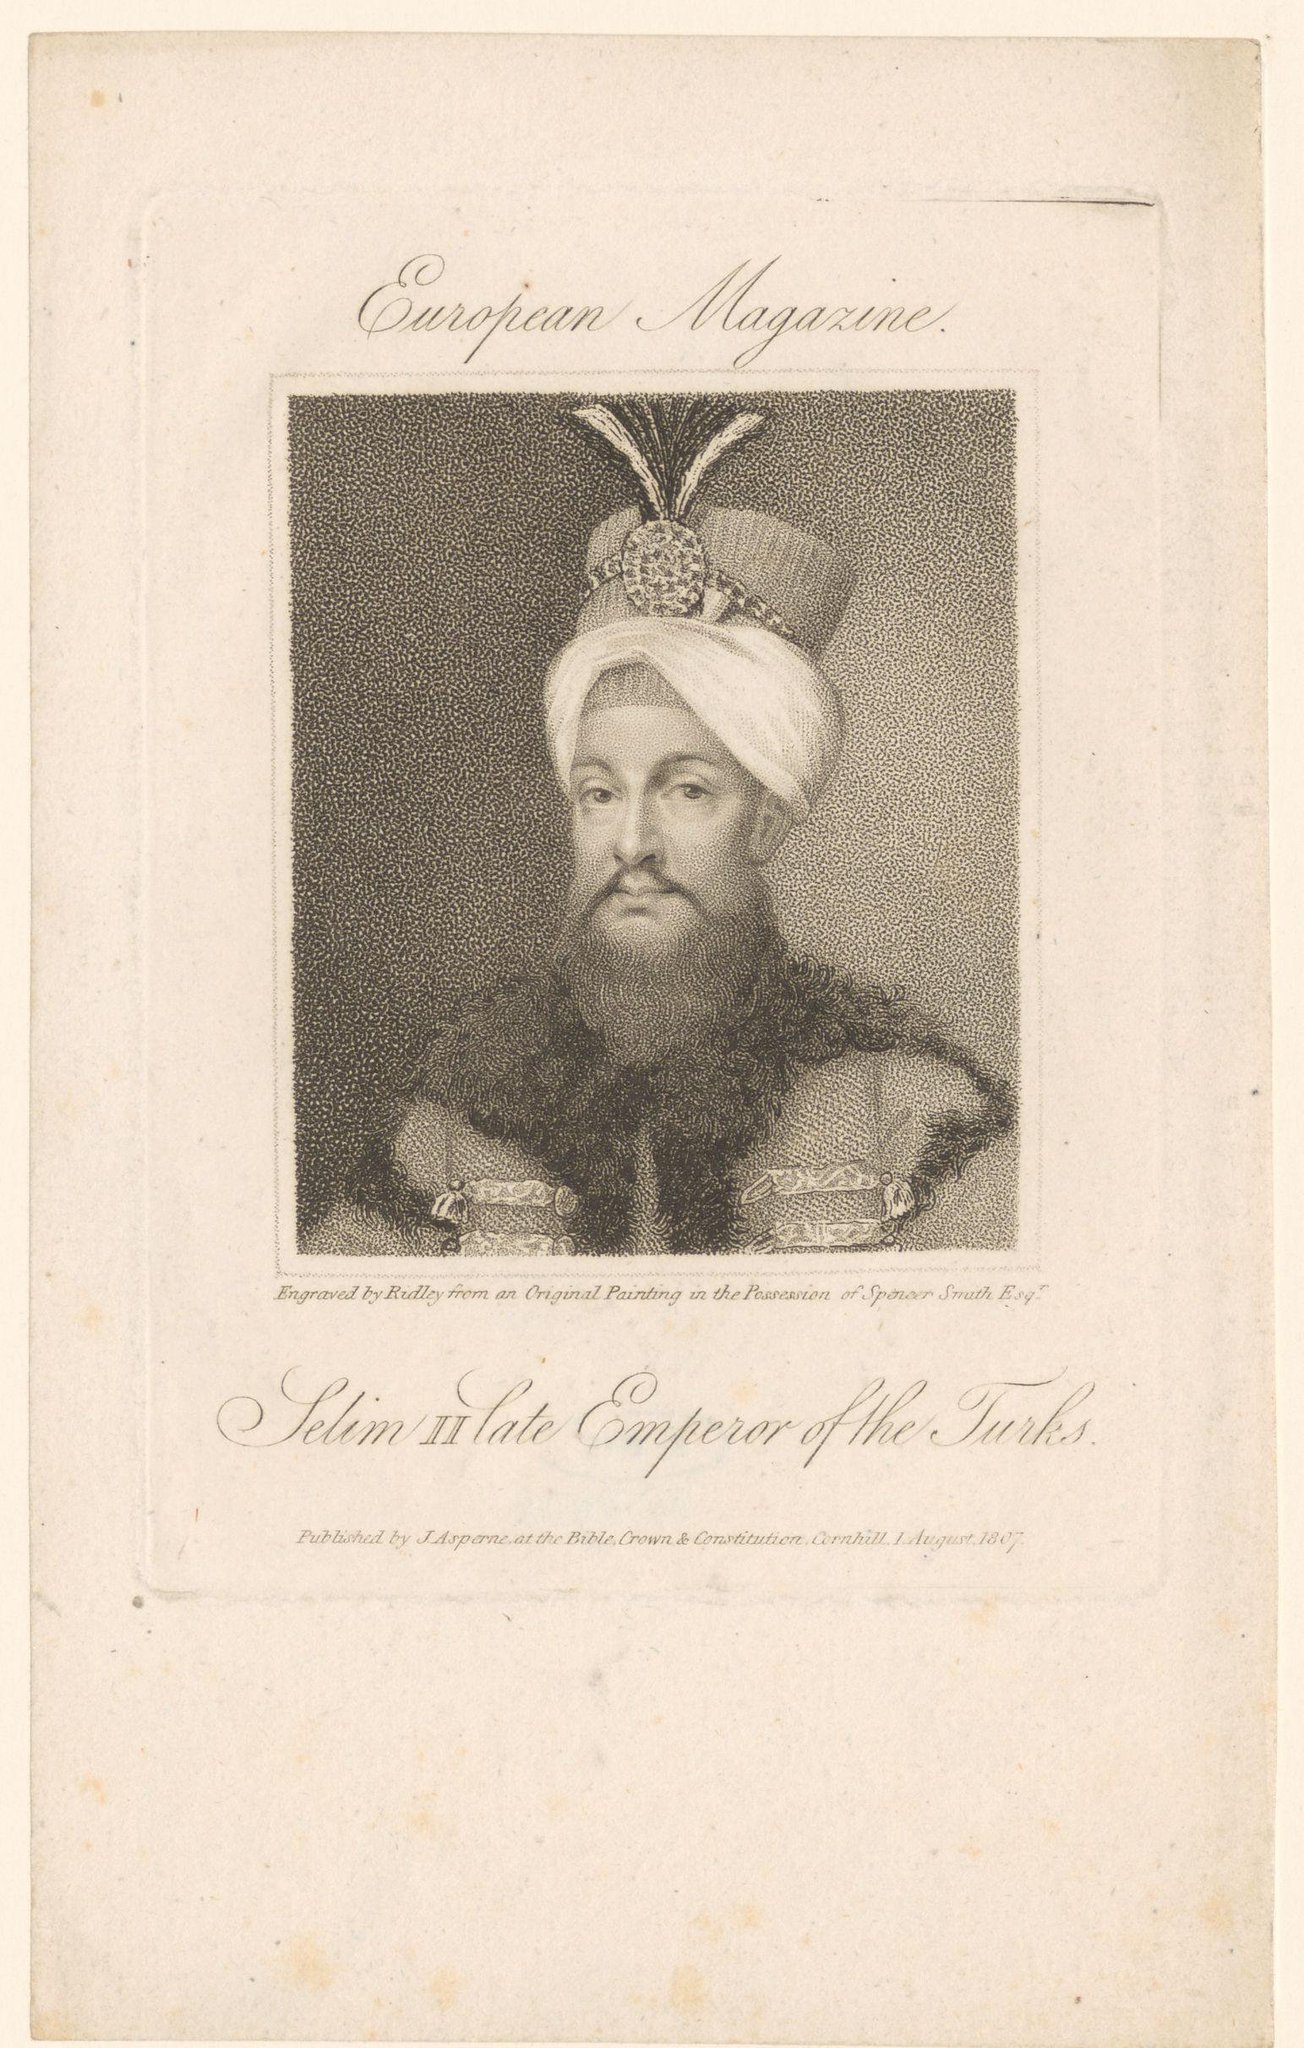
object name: print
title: Selim II late Emperor of the Turks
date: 1807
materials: paper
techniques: stippling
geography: london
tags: historical persons, ruler, sovereign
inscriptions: collector's mark: Lugt 2228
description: Prent gebruikt in: European Magazine (1807).